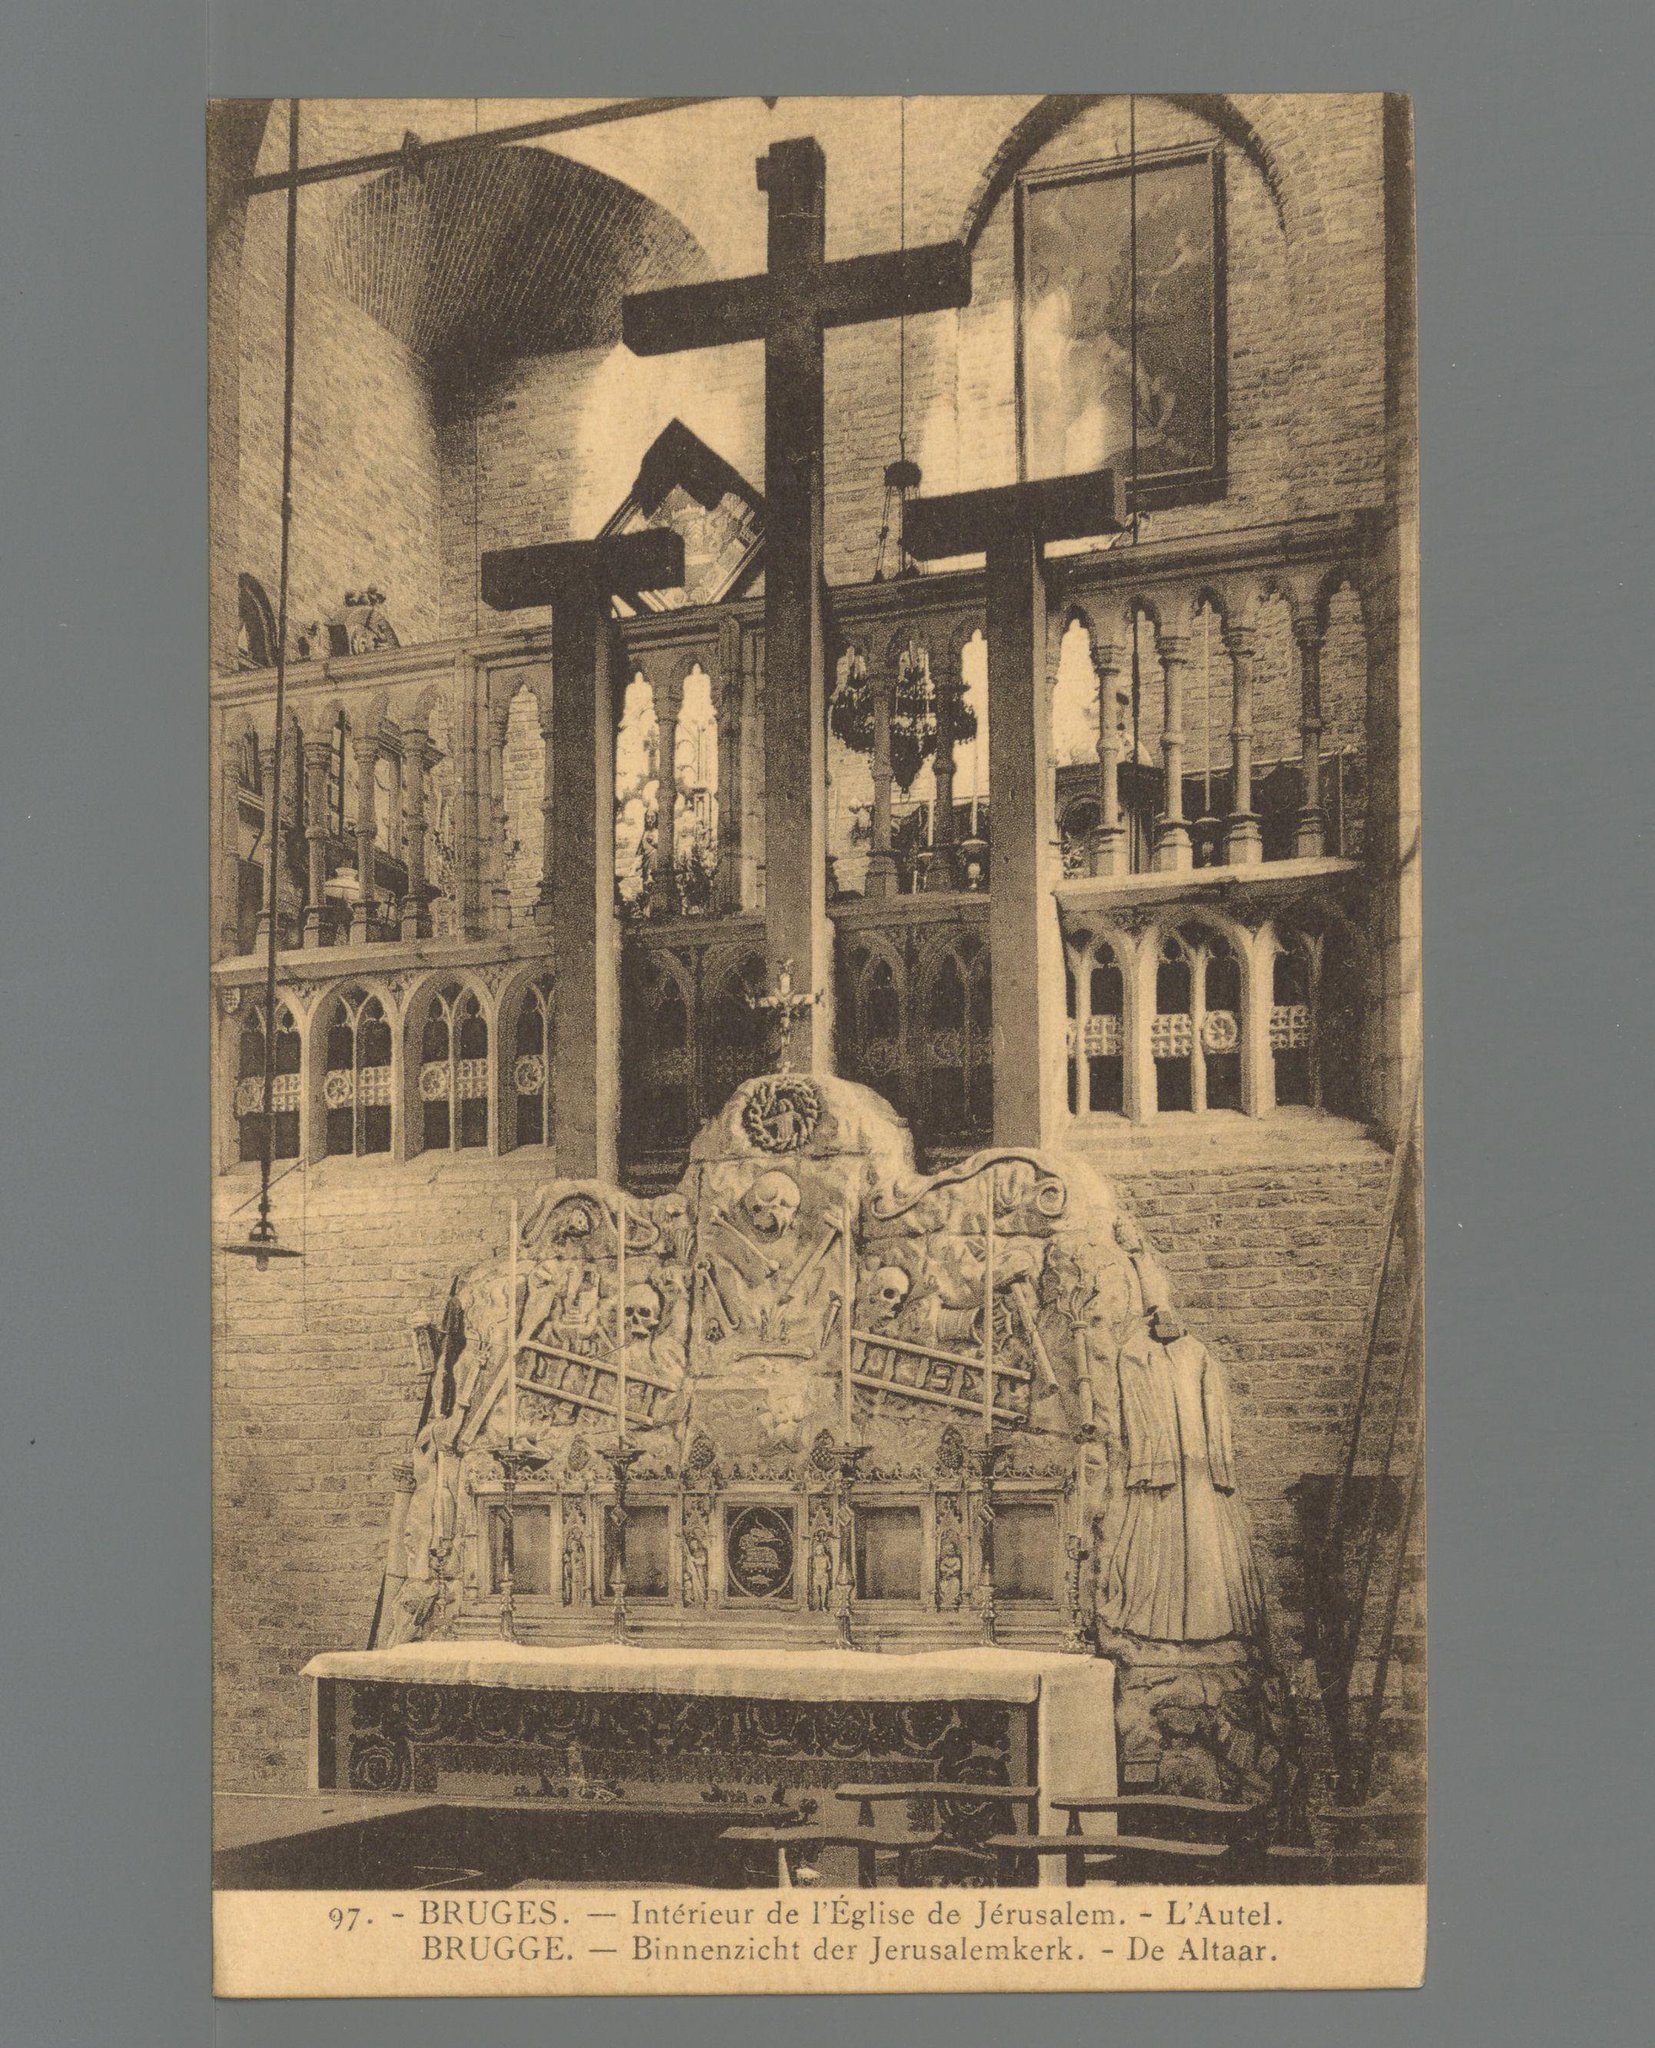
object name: photomechanical print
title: Bruges. Intérieur de l'Église de Jerusalem. L'Autel / Brugge. Binnenzicht der Jerusalemkerk. De Altaar.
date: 1906-1930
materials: cardboard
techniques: photograph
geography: bruges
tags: interior of church, altar